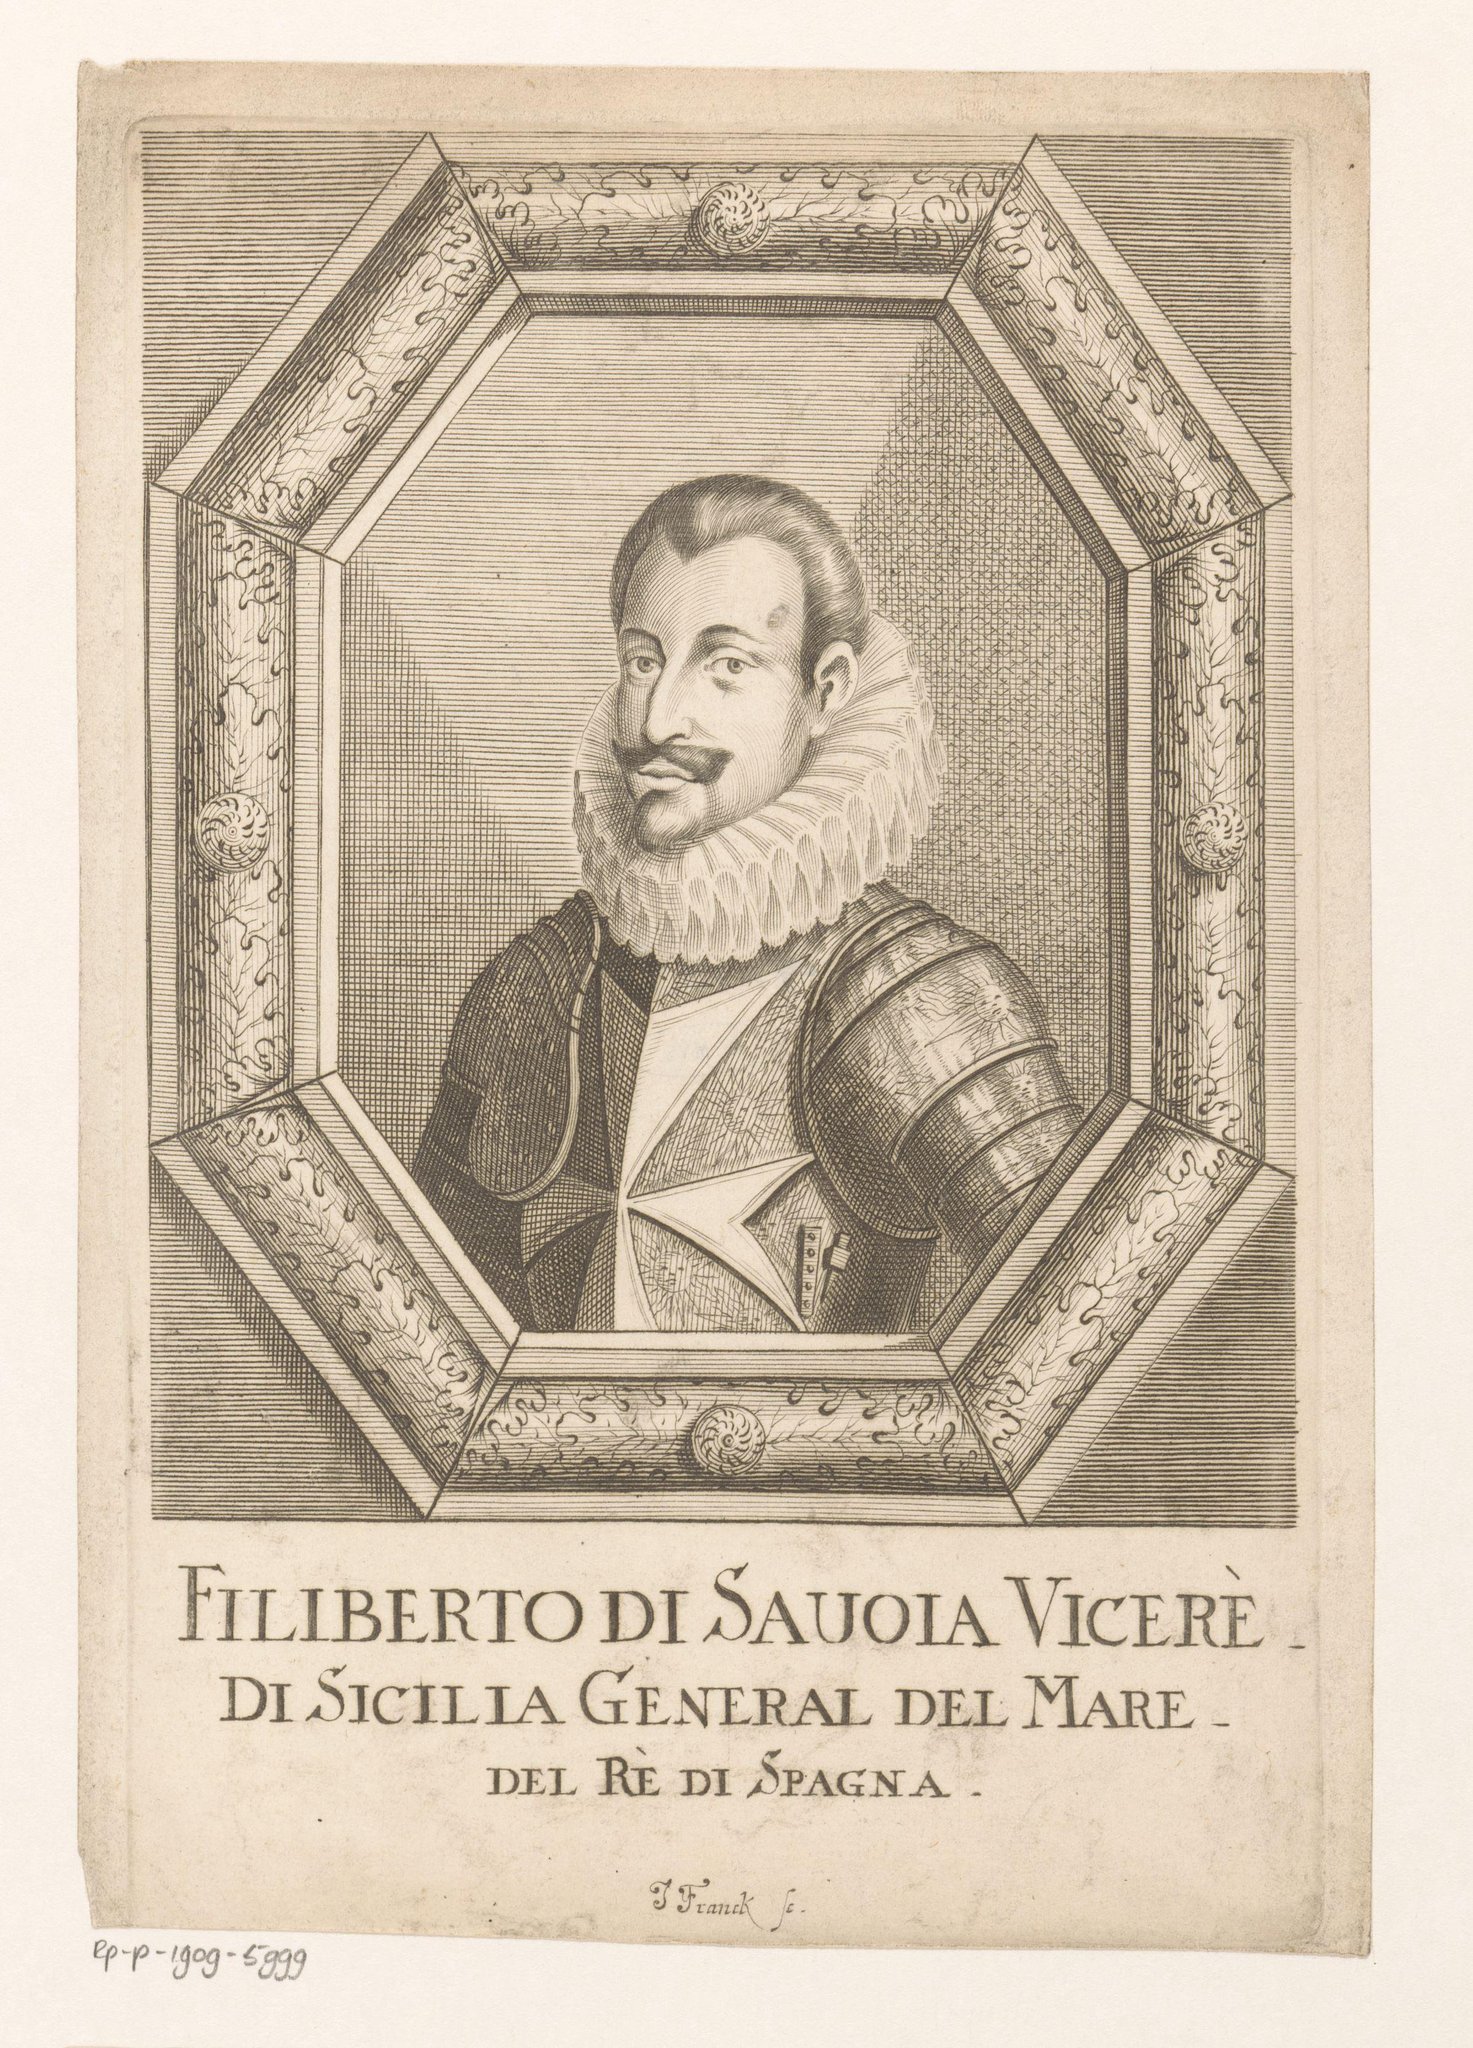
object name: print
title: Portret van Emanuel Philibert, hertog van Savoye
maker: johann franck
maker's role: print maker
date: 1672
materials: paper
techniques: engraving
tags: emanuel filibert (hertog van savoye), armour, historical persons, sun represented as face, wheel, etc., military orders, e.g.: knights templars, knights of malta, teutonic knights ~ roman catholic church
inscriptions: collector's mark: Lugt 2228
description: Prent gebruikt voor: Priorato, Galeazzo Gualdo. Historia di Ferdinando terzo. Wenen: s.n., 1672.